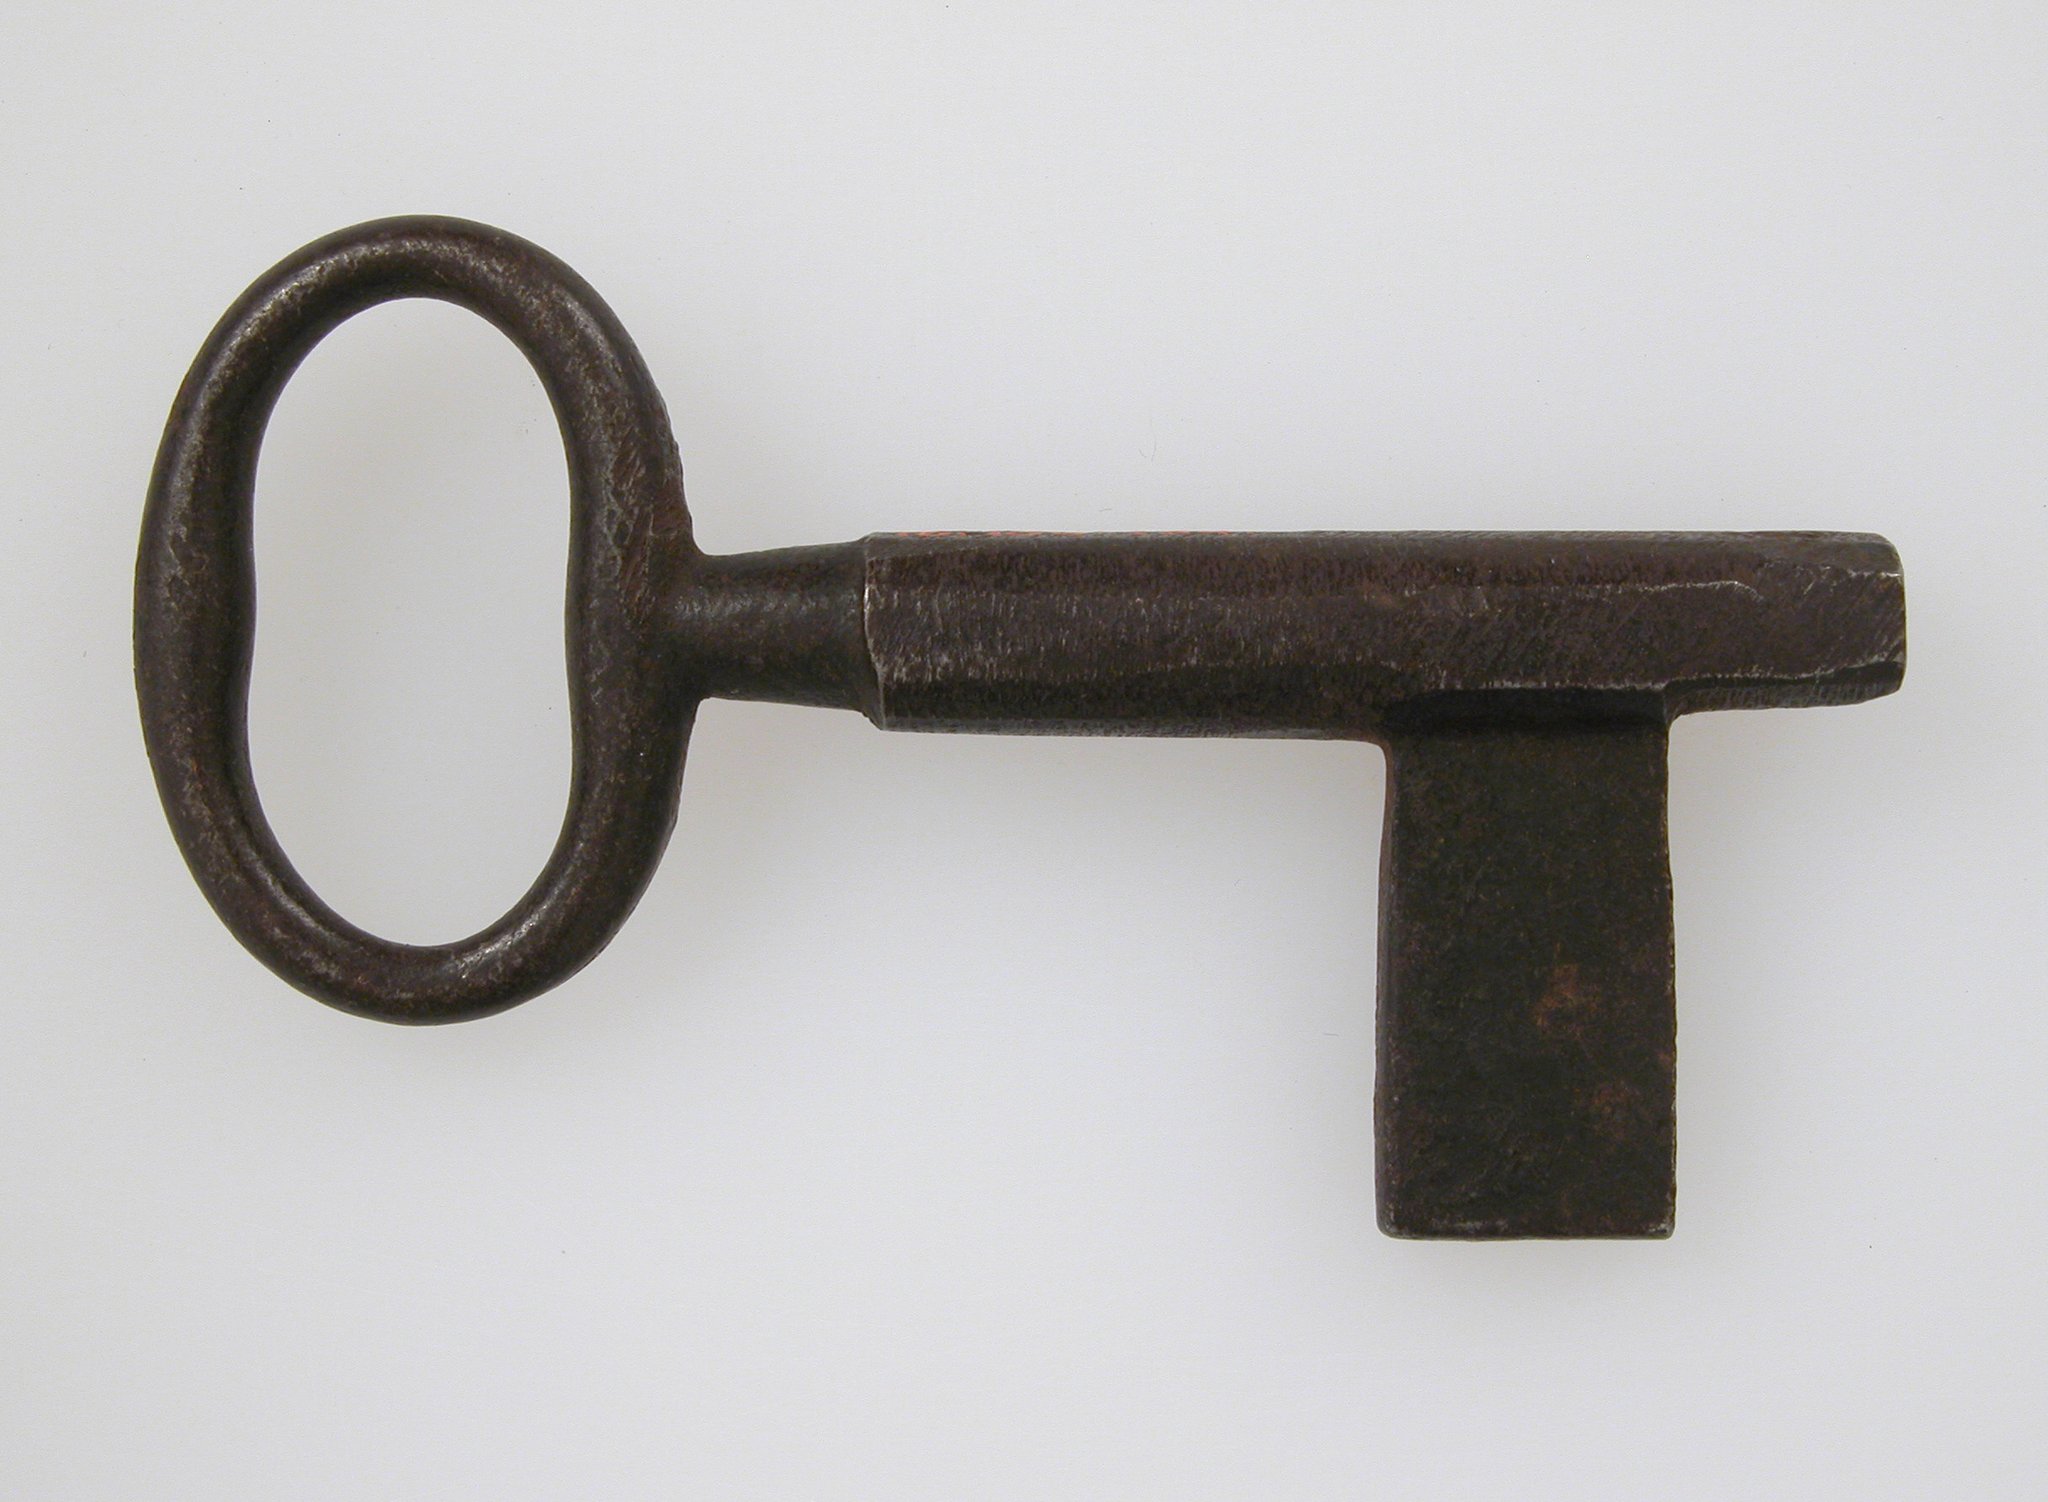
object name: key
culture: german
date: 1401-1500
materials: iron